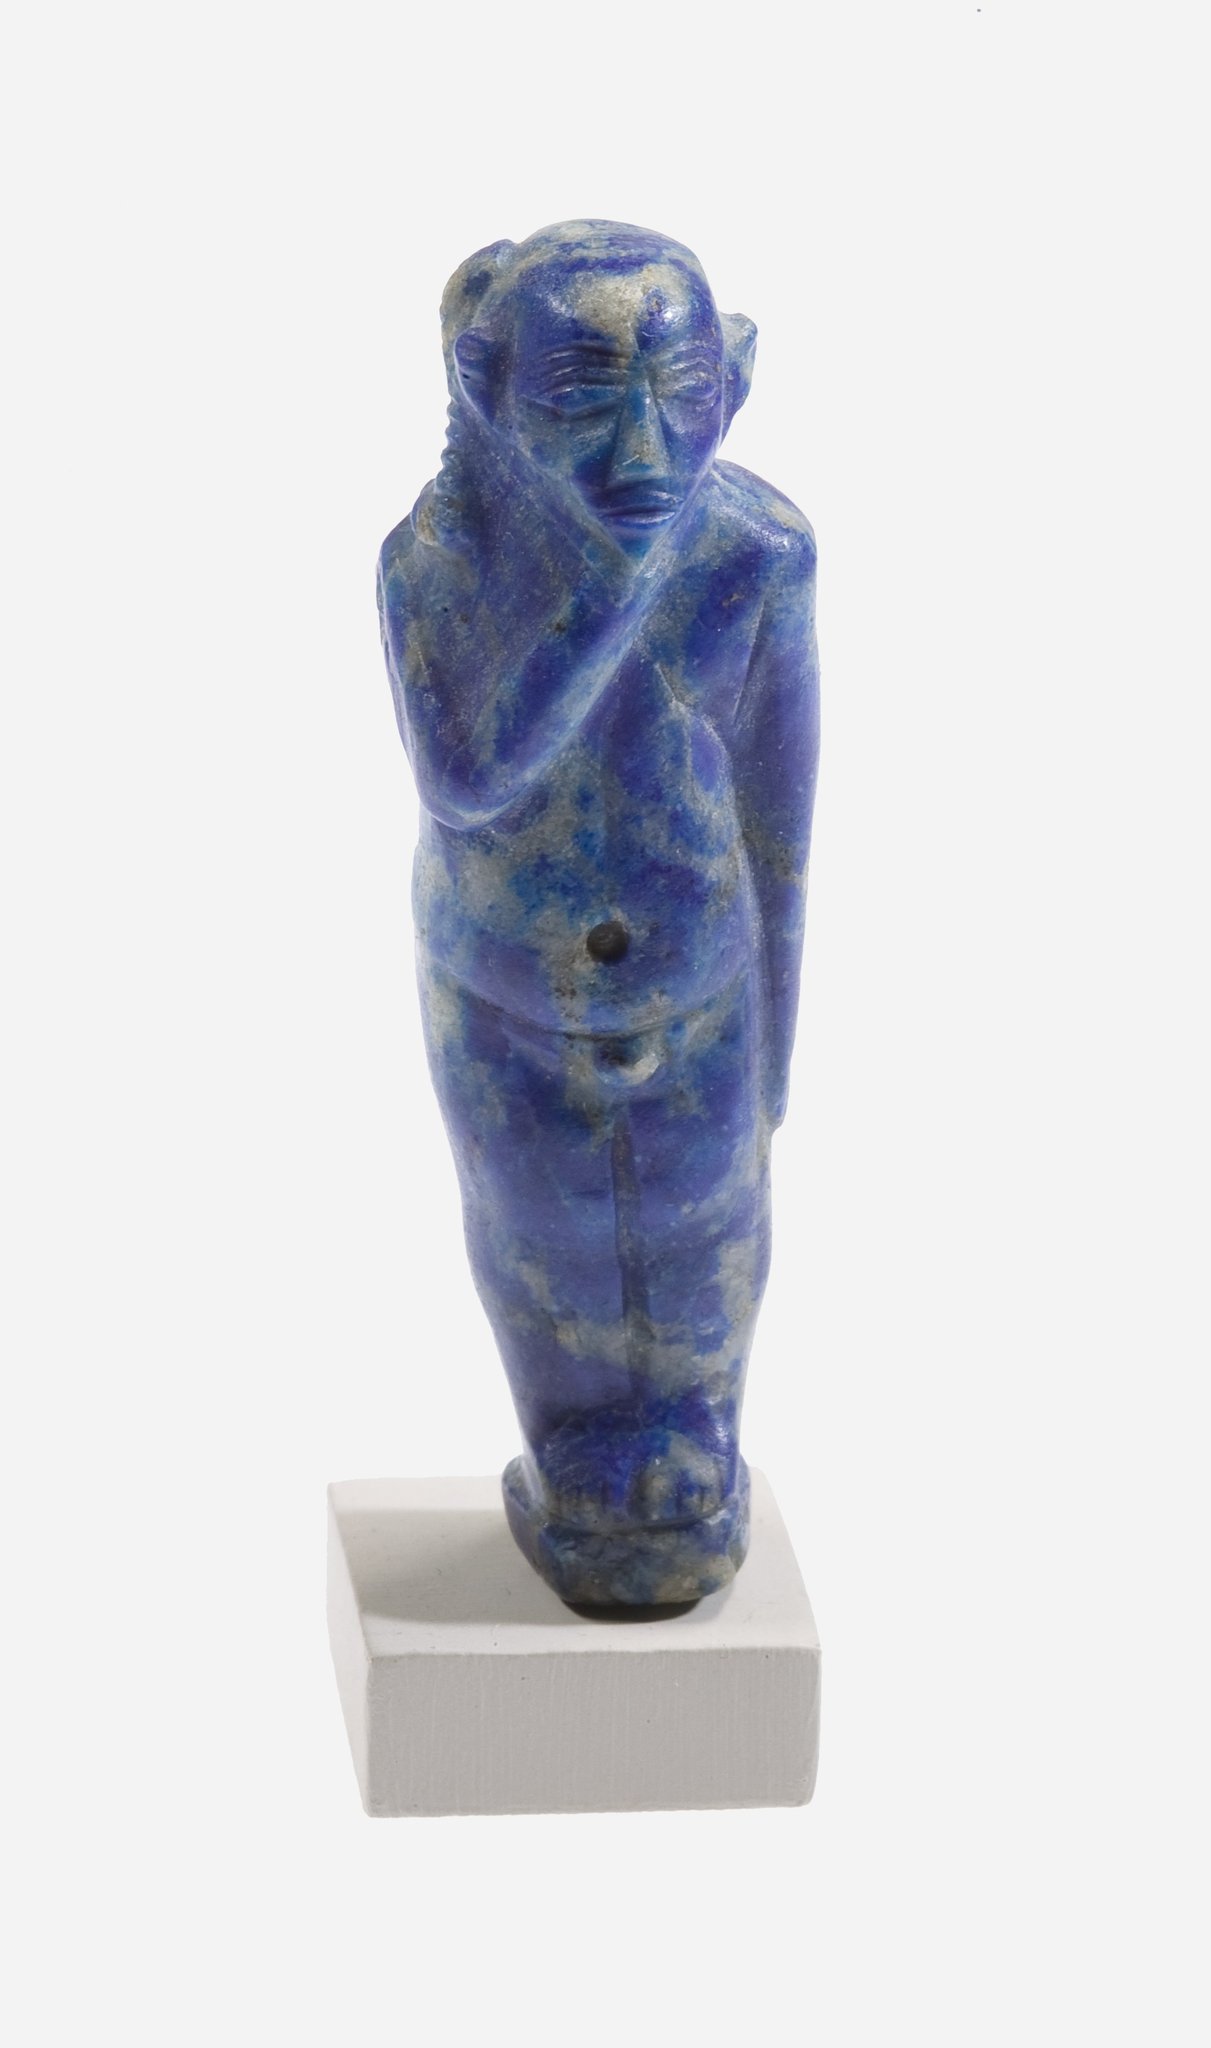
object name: amulet, harpokrates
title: Amulet of Harpokrates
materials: lapis lazuli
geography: egypt